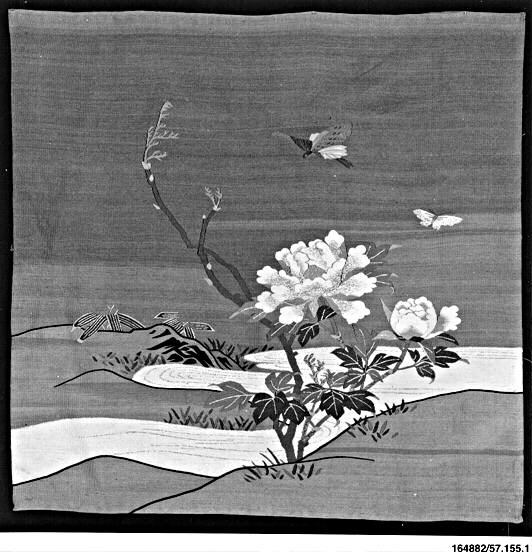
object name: gift cloth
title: Gift Cloth (Fukusa)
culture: japanese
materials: silk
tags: birds,butterflies,flowers